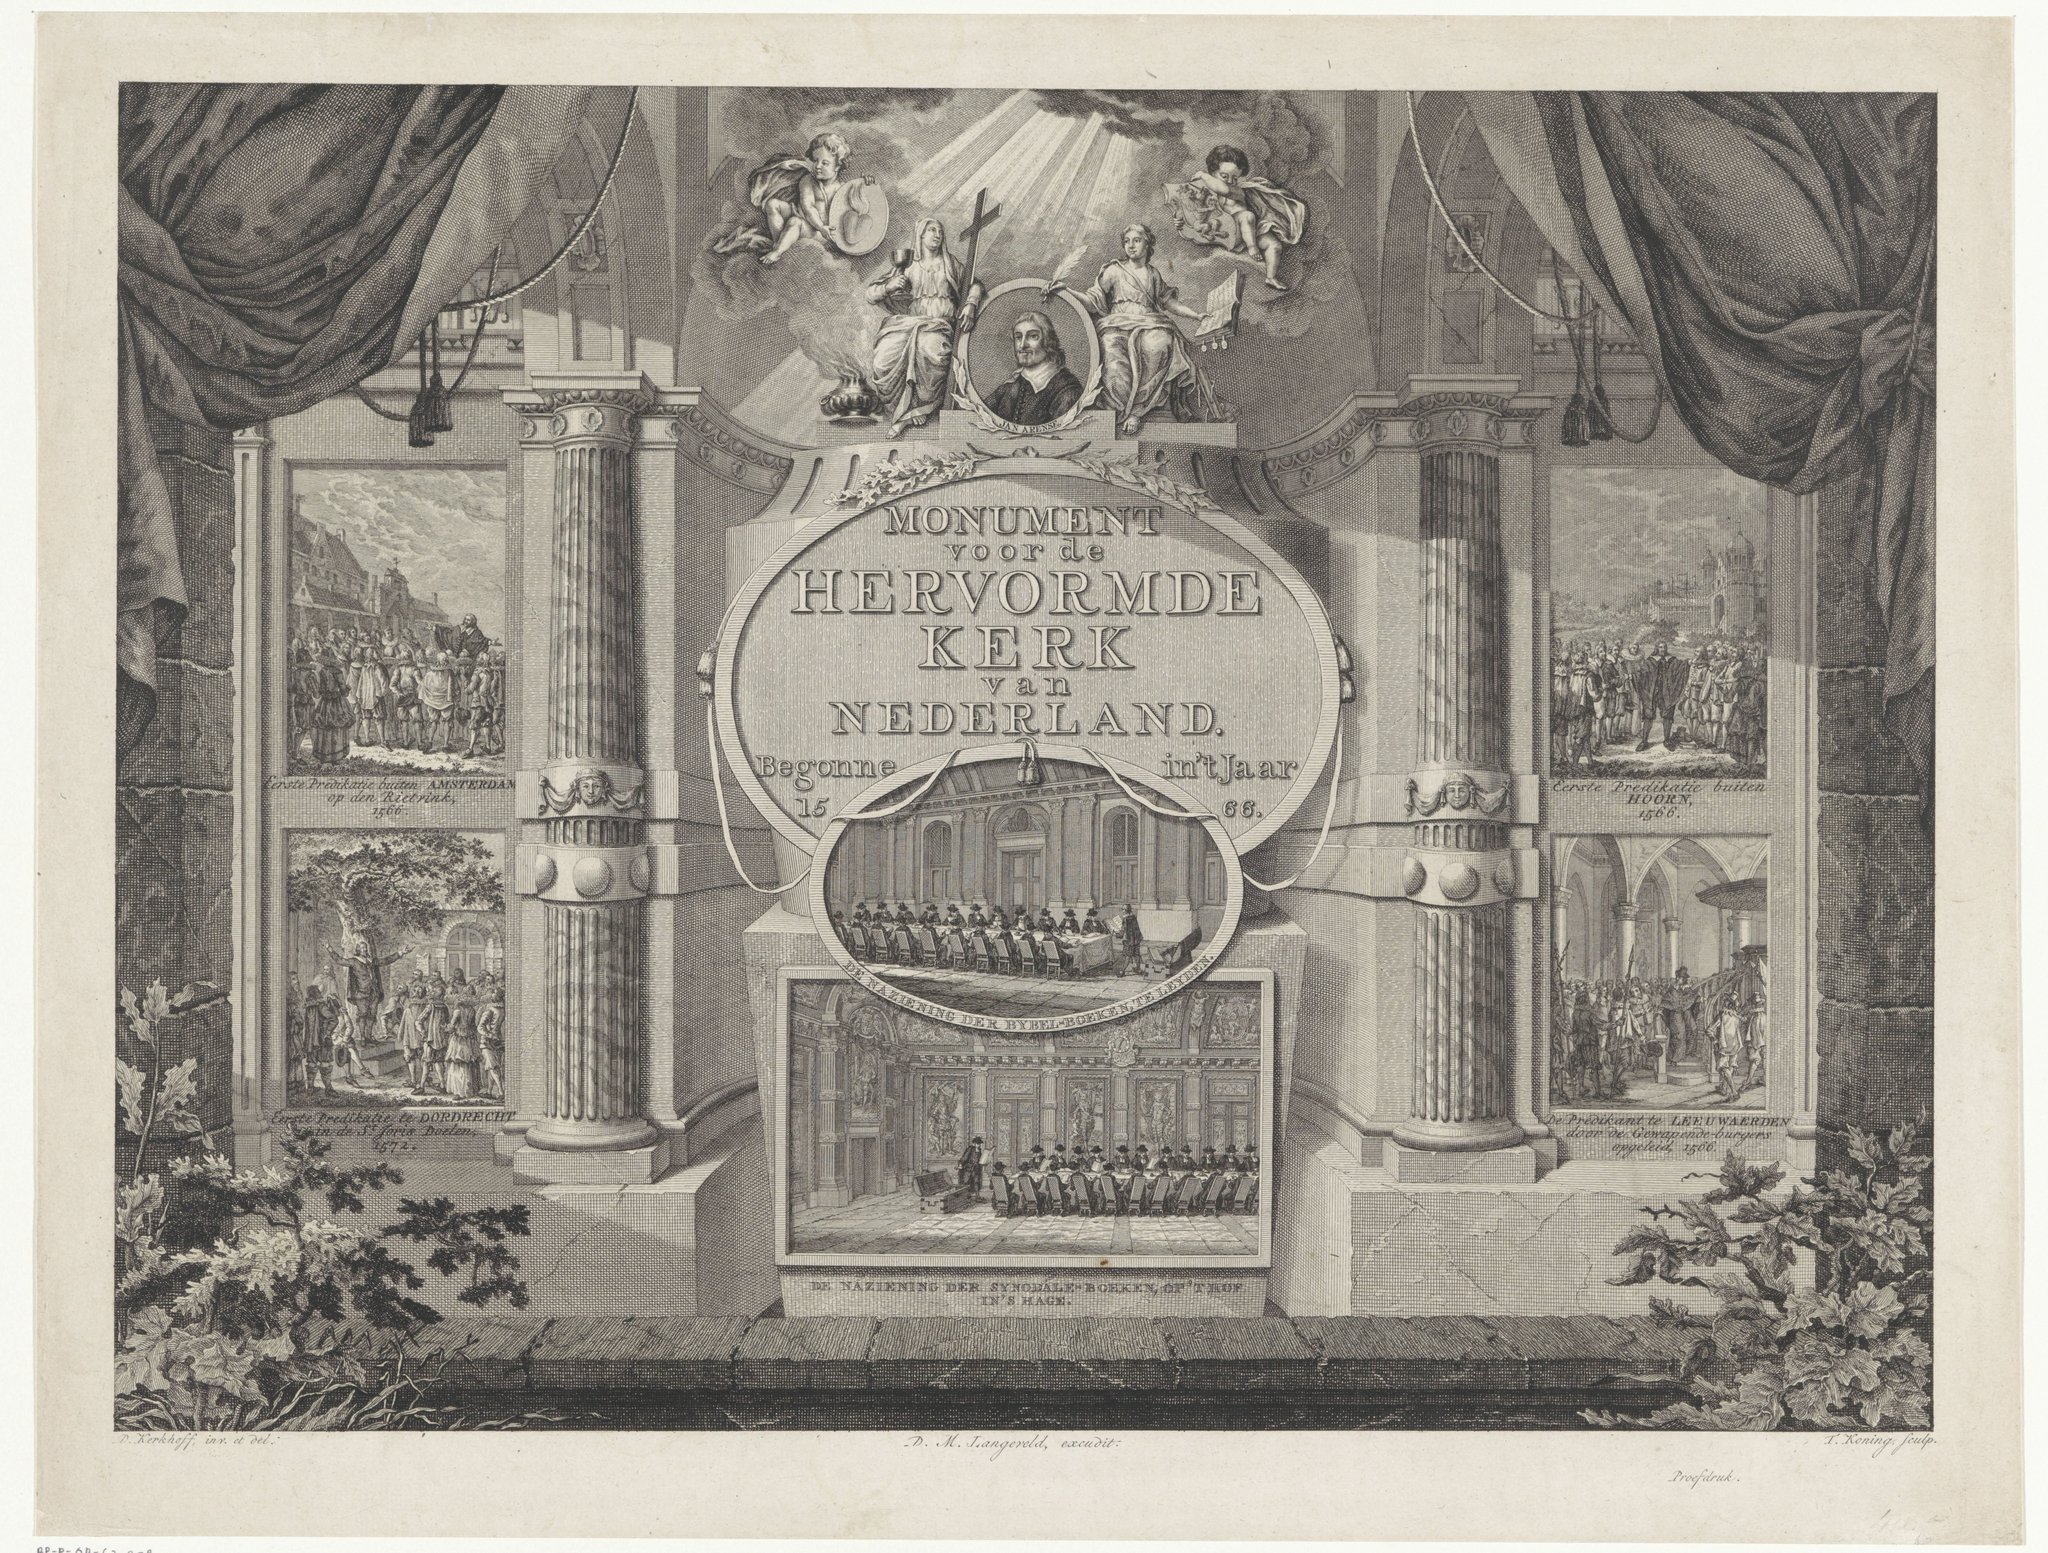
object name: print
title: Monument voor de Hervormde Kerk van Nederland, vanaf 1566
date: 1780-1796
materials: paper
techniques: engraving, etching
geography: amsterdam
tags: leiden, the hague, dordrecht, amsterdam, hoorn (north holland)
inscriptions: collector's mark: Lugt 2228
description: Monument voor de Hervormde Kerk van Nederland, vanaf 1566. Boven een klein portret van de eerste lutherse predikant Jan Arentsz, links en rechts scènes van de eerste calvinistische predikingen in de jaren 1566 en 1572 te Amsterdam, Hoorn, Leeuwarden en Dordrecht. In het midden het nazien van de bijbelvertaling te Leiden en Den Haag. Zinneprent op de Hervorming.